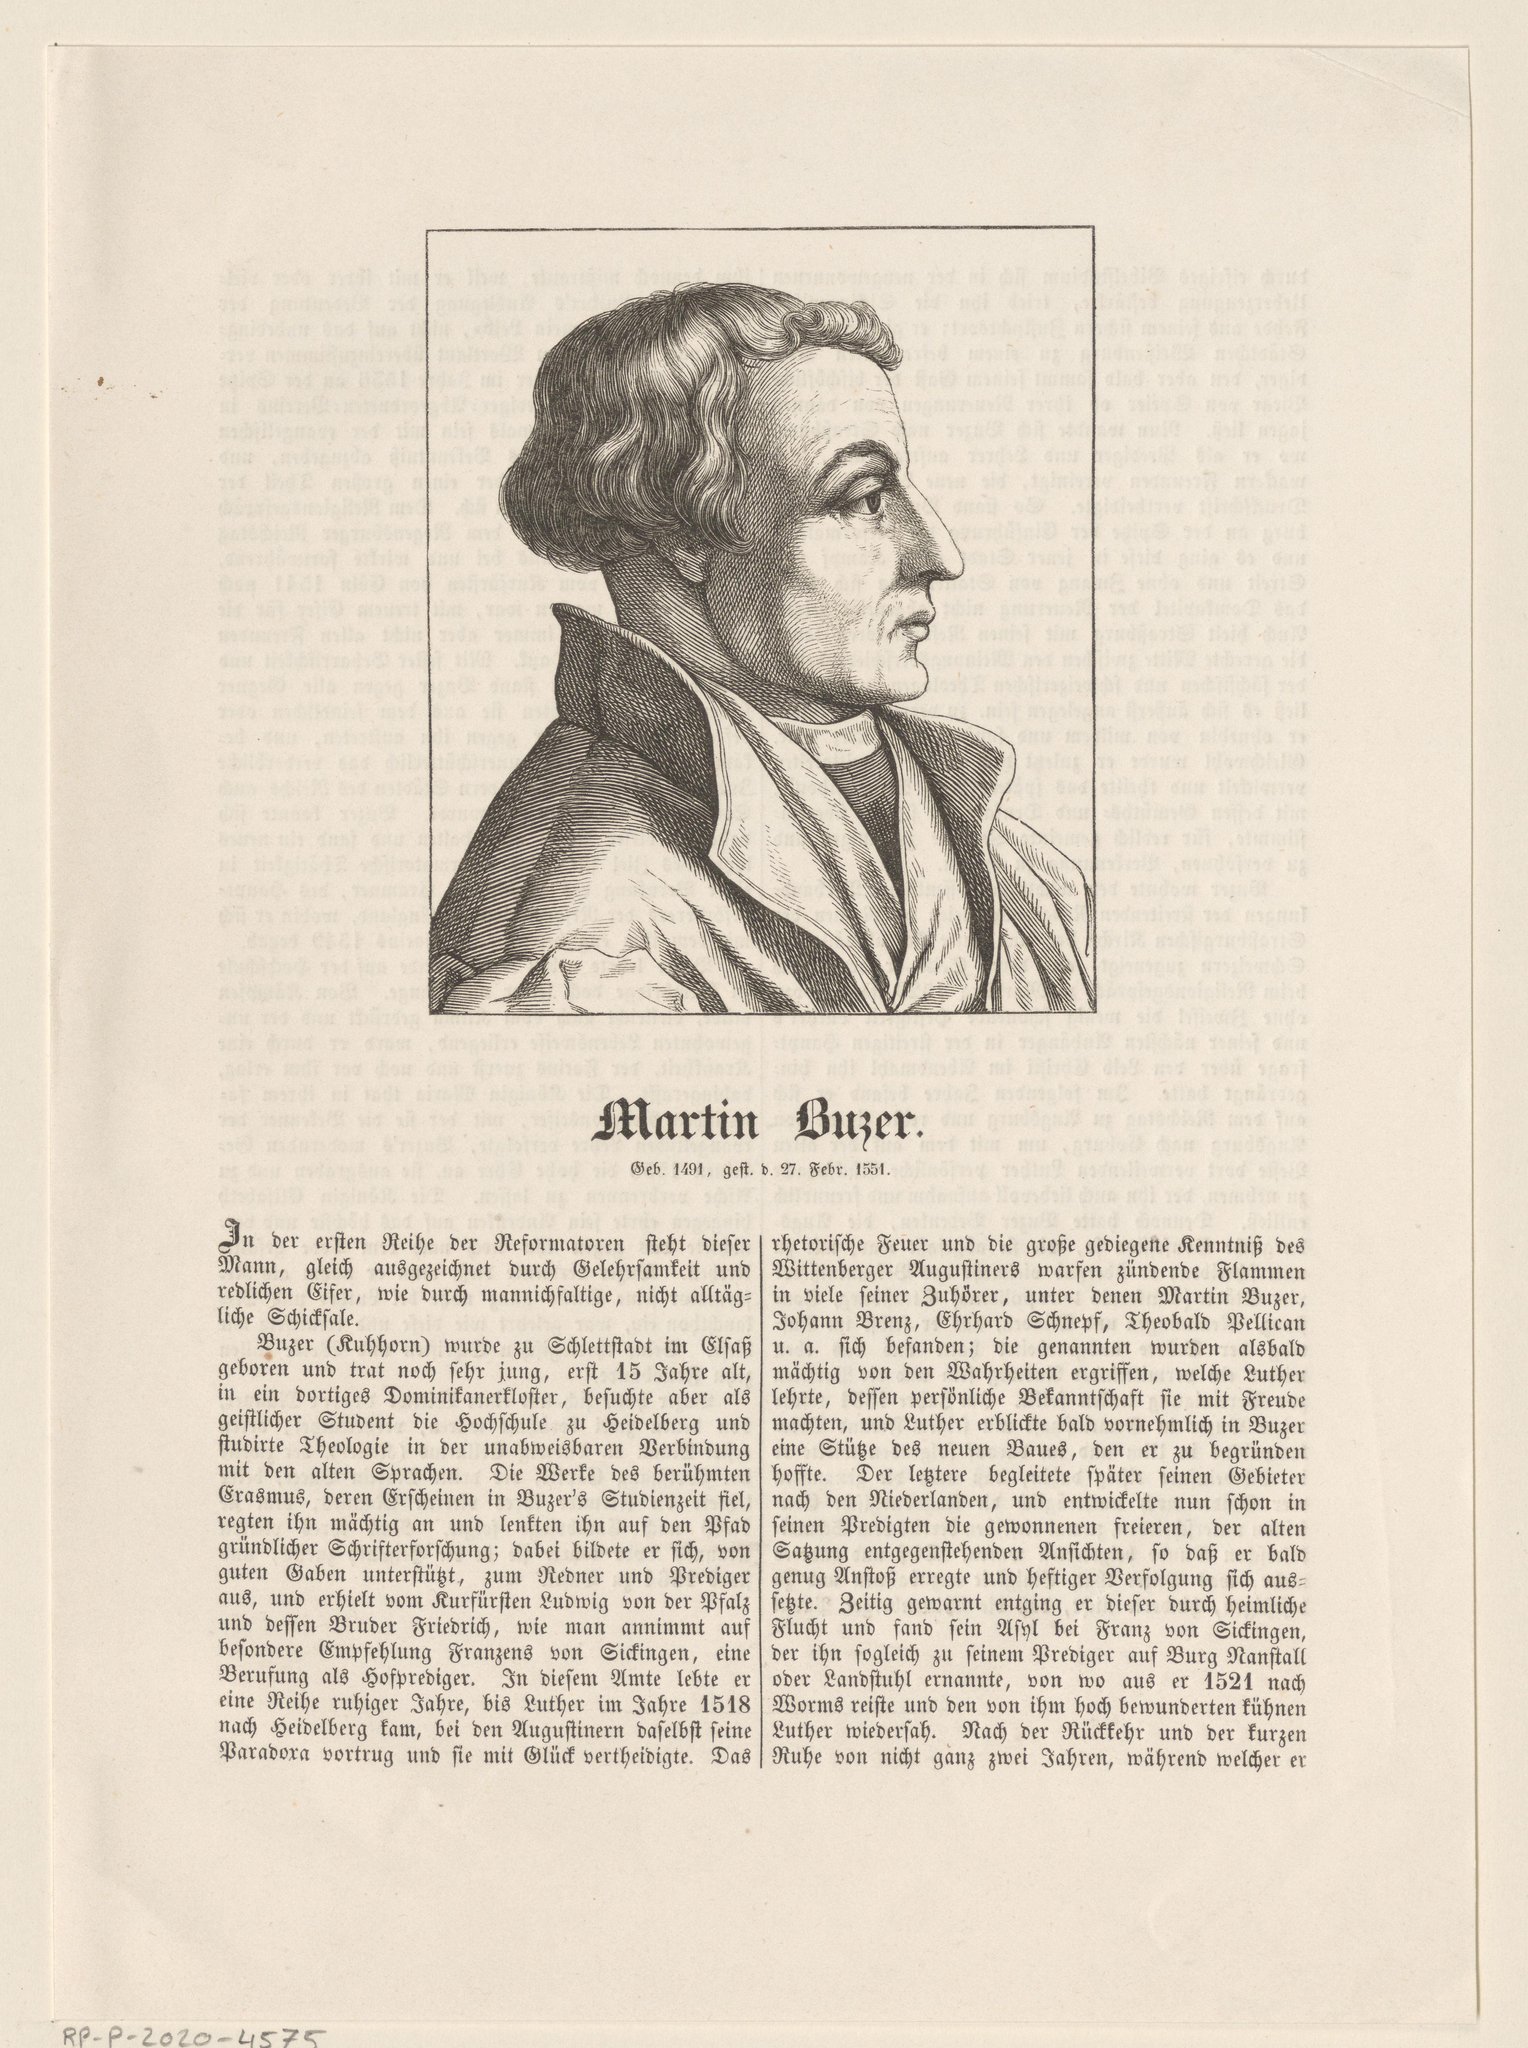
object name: book illustration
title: Portret van Martin Bucer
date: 1854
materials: paper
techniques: letterpress printing, engraving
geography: leipzig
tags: theologian, historical persons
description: Prent uit: Bechstein, Ludwig. Zweihundert deutsche Männer in Bildnissen und Lebensbeschreibungen. Leipzig: Georg Wigand, 1854.